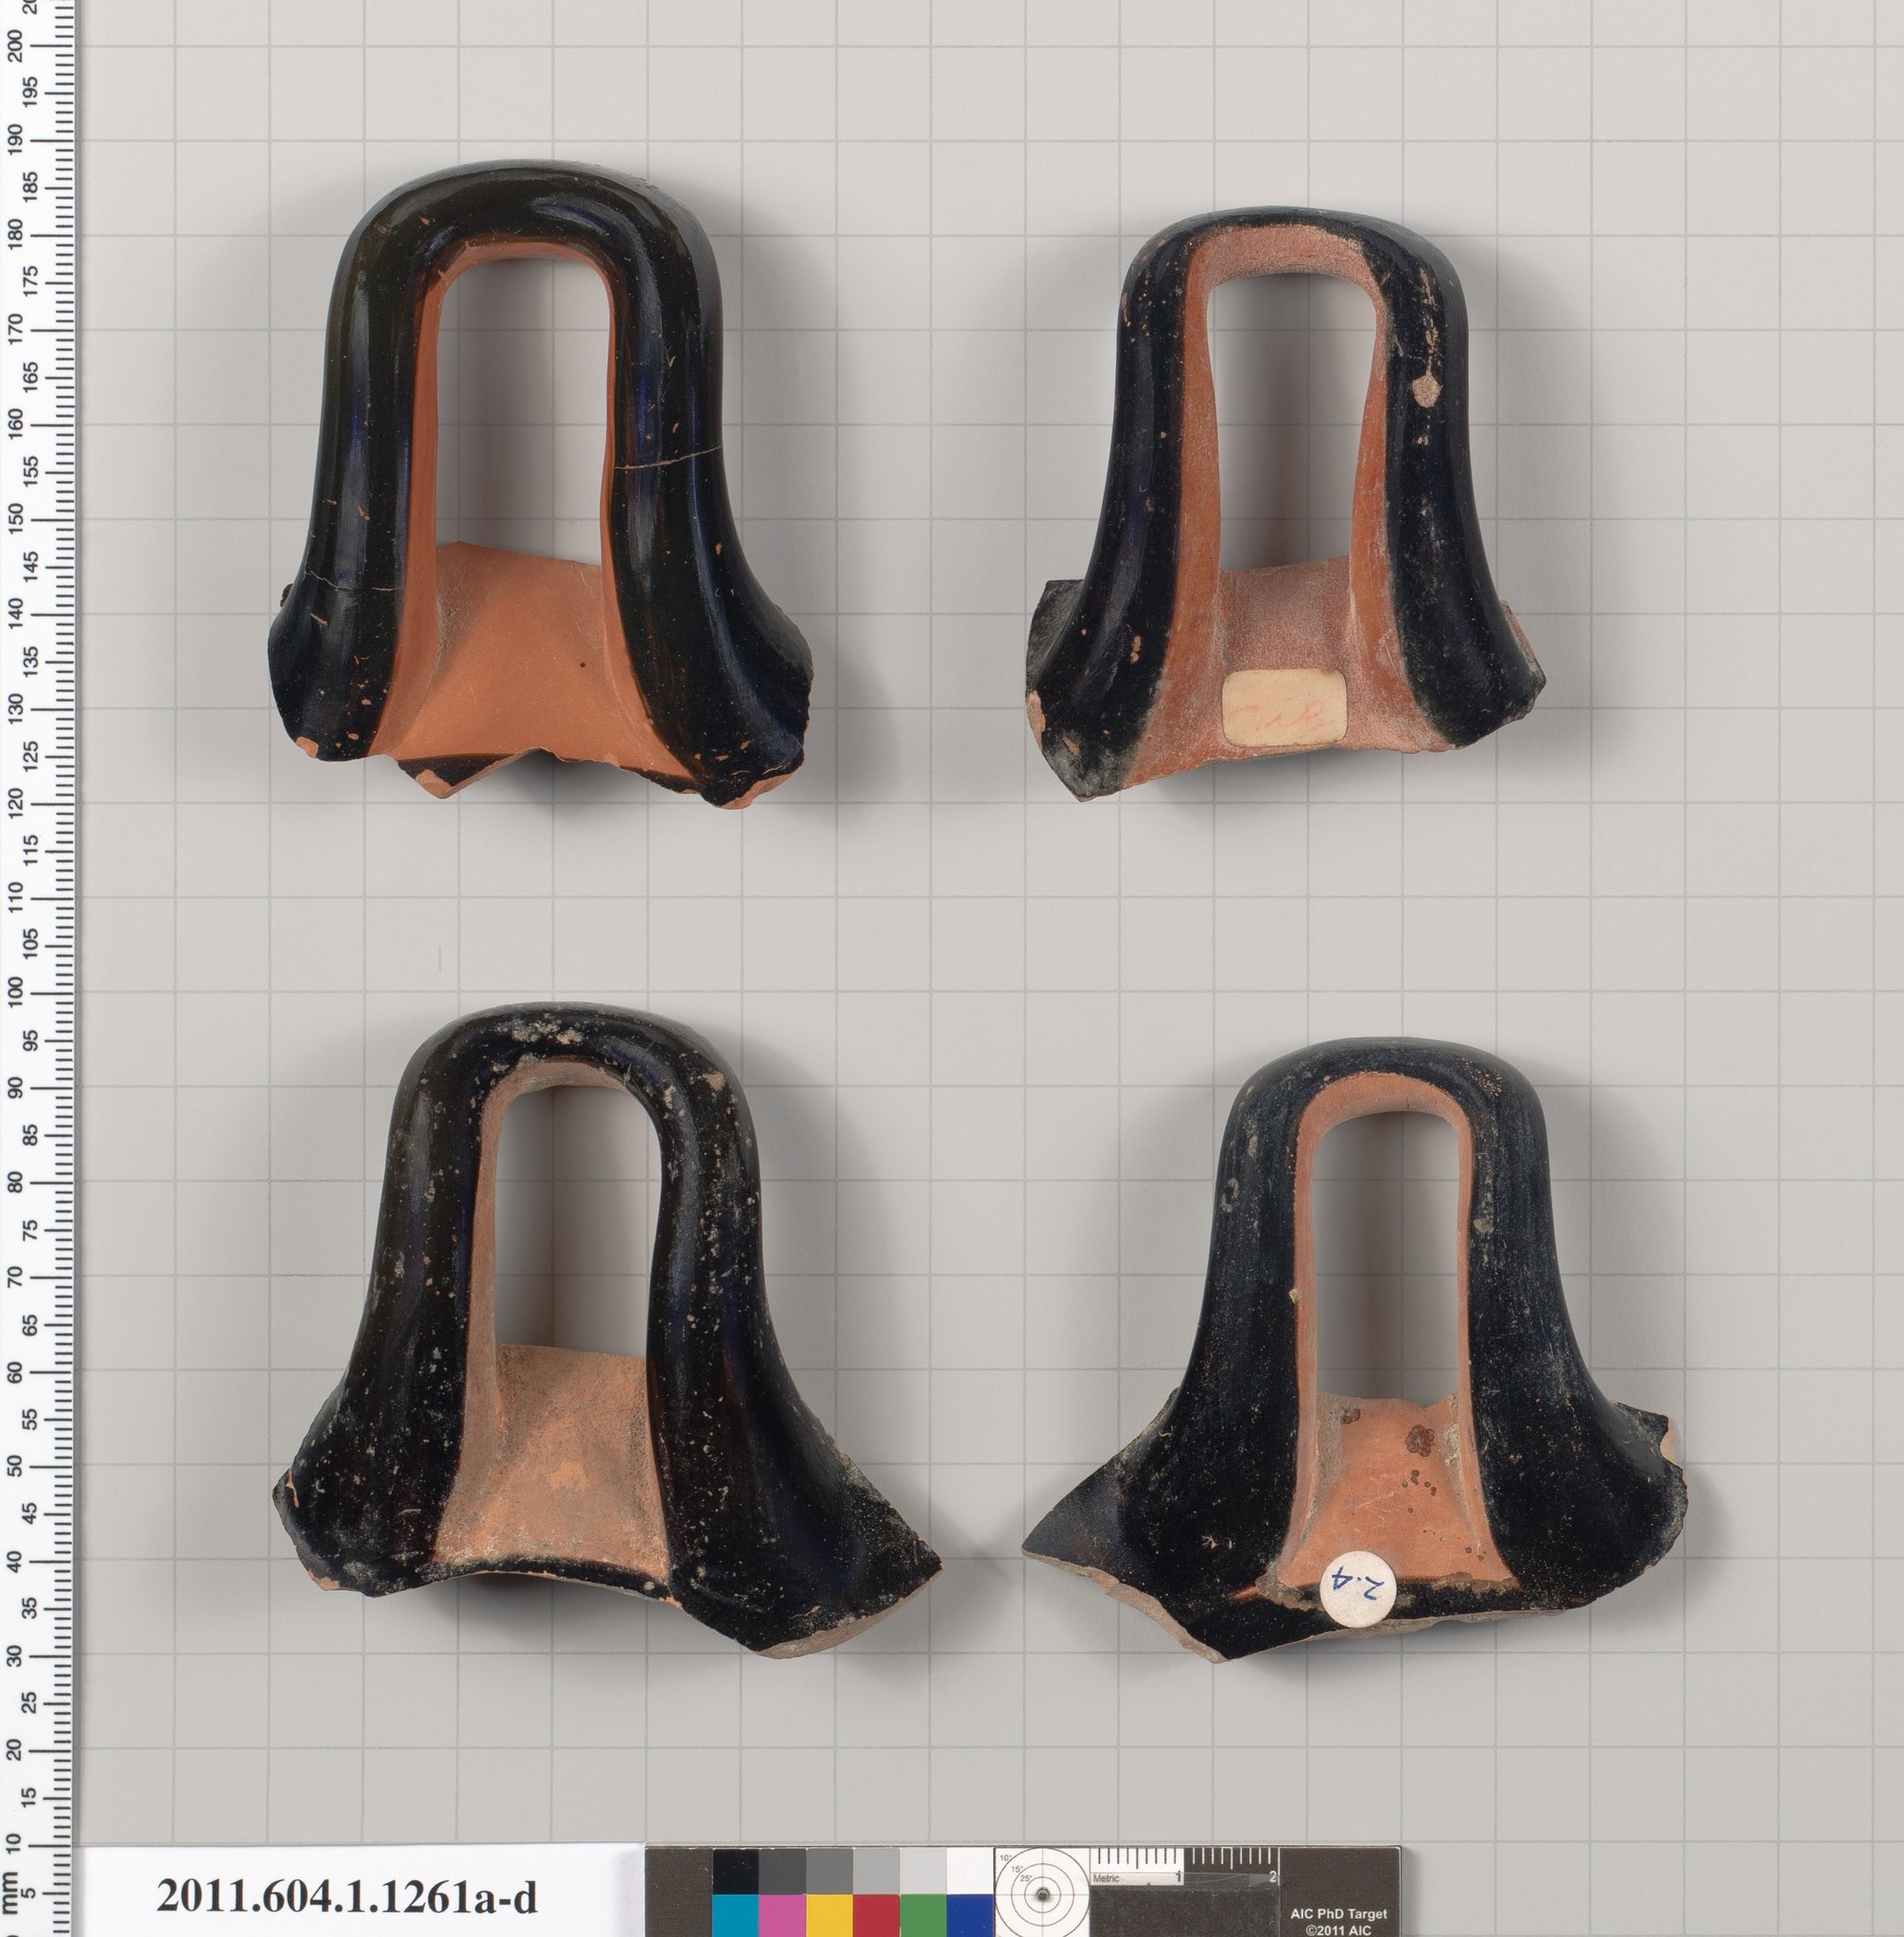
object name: kylix fragment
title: Terracotta fragments of kylikes (drinking cups)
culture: greek, attic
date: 500-401 BCE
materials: terracotta